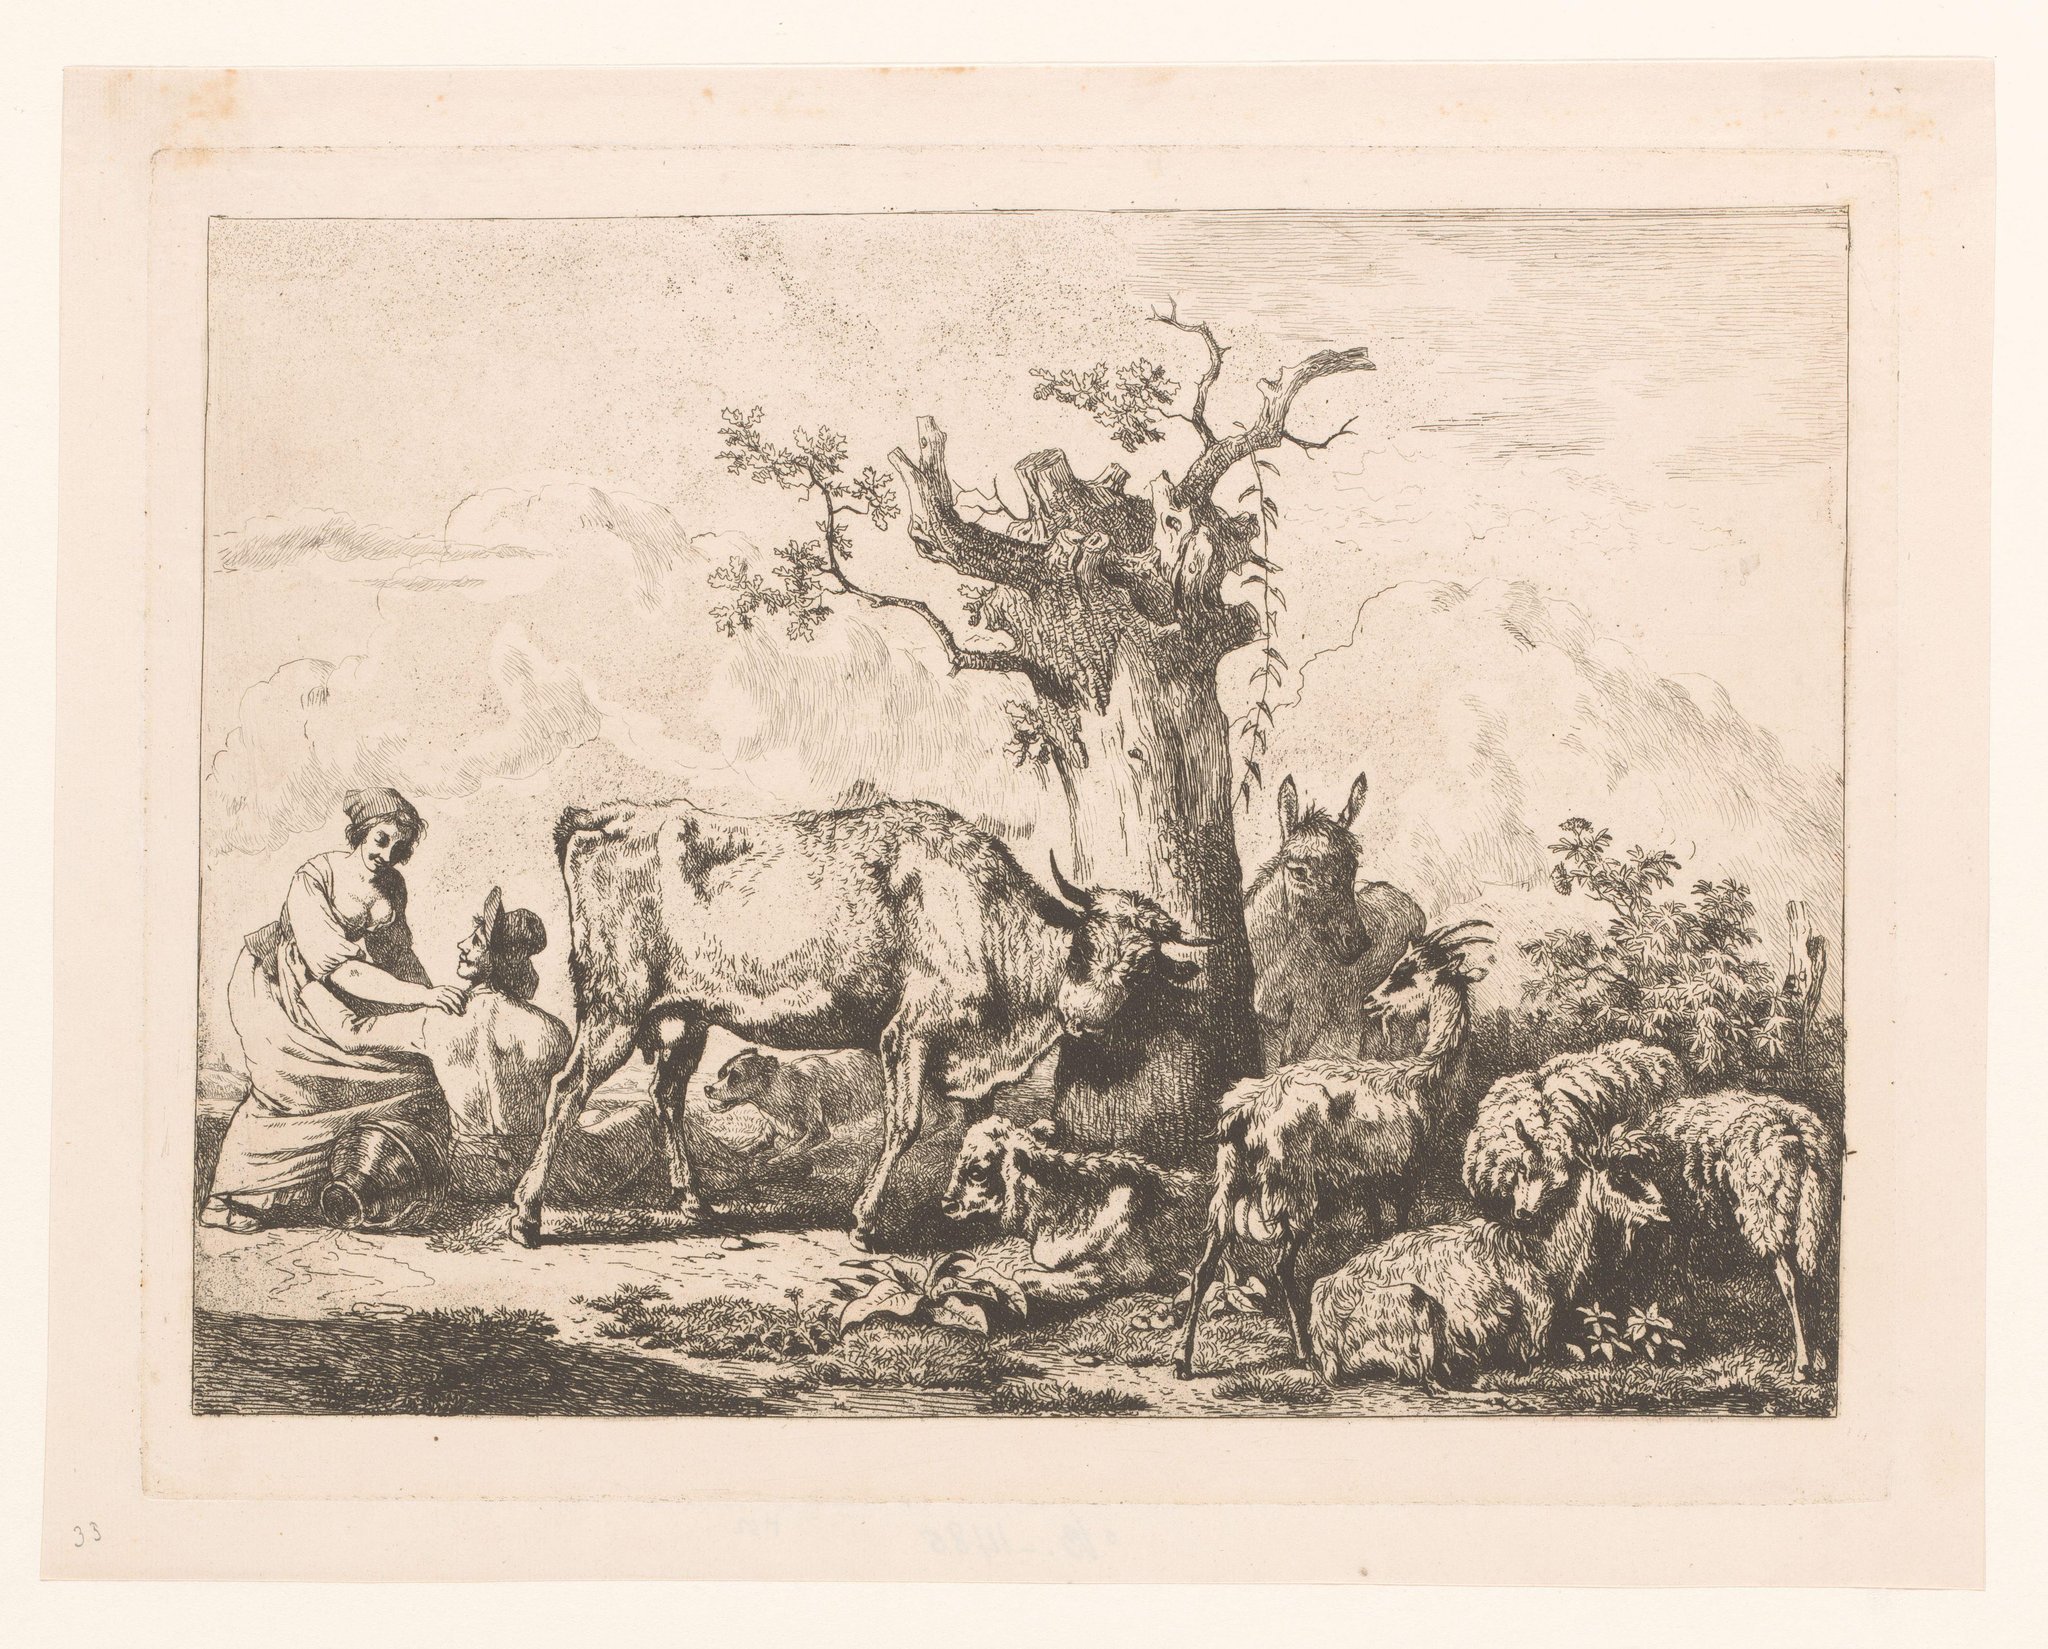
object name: print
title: Landschap met vee rondom een boom en een man en vrouw die elkaar omarmen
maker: jean louis demarne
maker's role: draughtsman, painter, print maker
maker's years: 1752-1829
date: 1762-1829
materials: paper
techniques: aquatint, etching, intaglio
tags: herding, herdsman, herdswoman, shepherd, shepherdess, cowherd, etc., cattle, couple of lovers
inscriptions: collector's mark: Lugt 1485, collector's mark: Lugt 2228